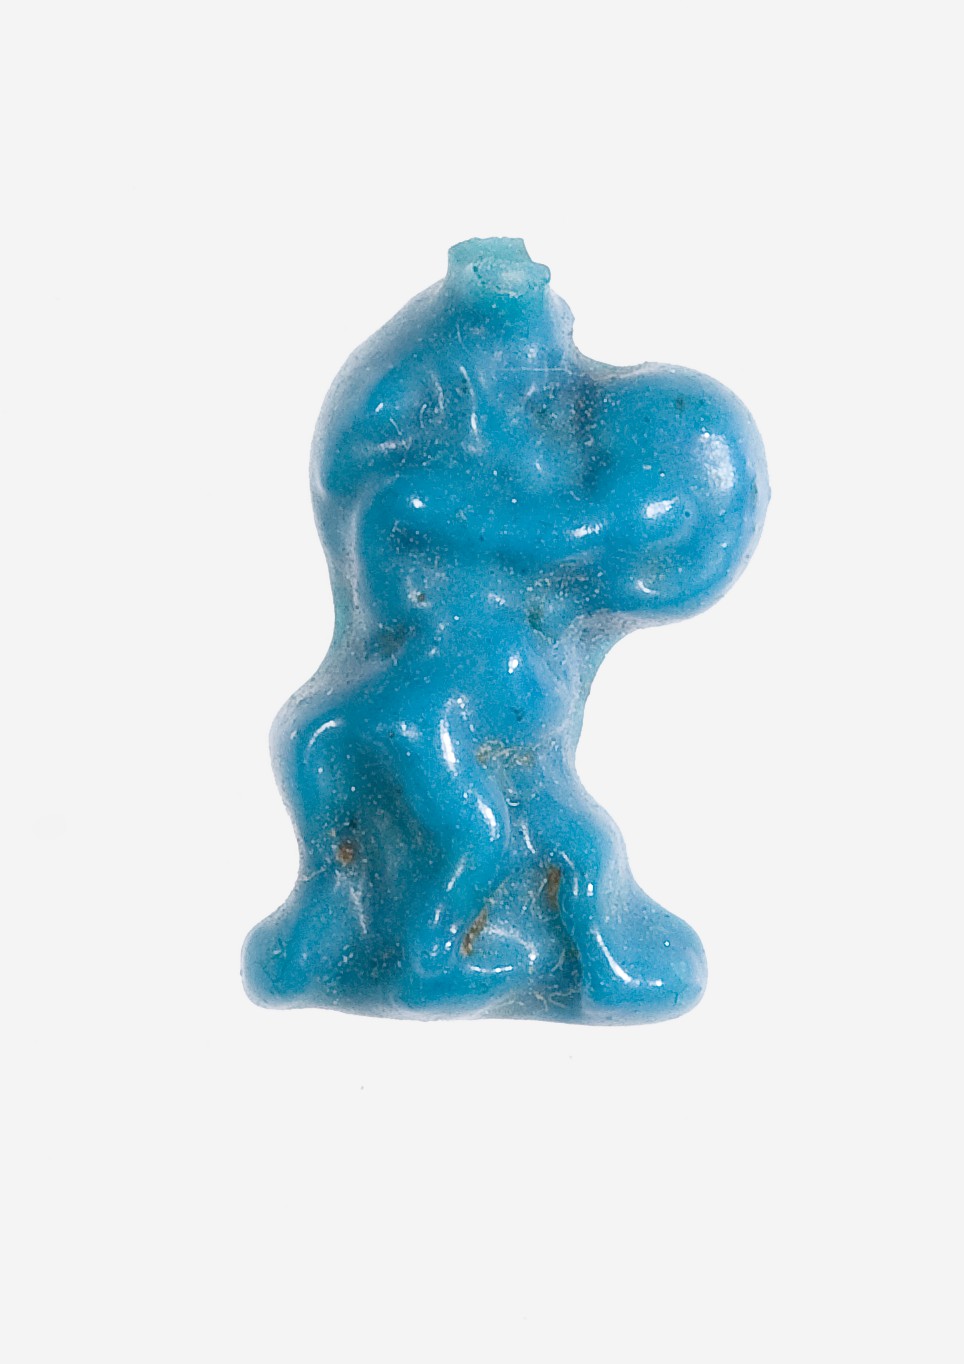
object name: pendant, be, tambourine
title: Amulet: Bes with tambourine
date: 1390-1352 BCE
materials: faience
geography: egypt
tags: bes